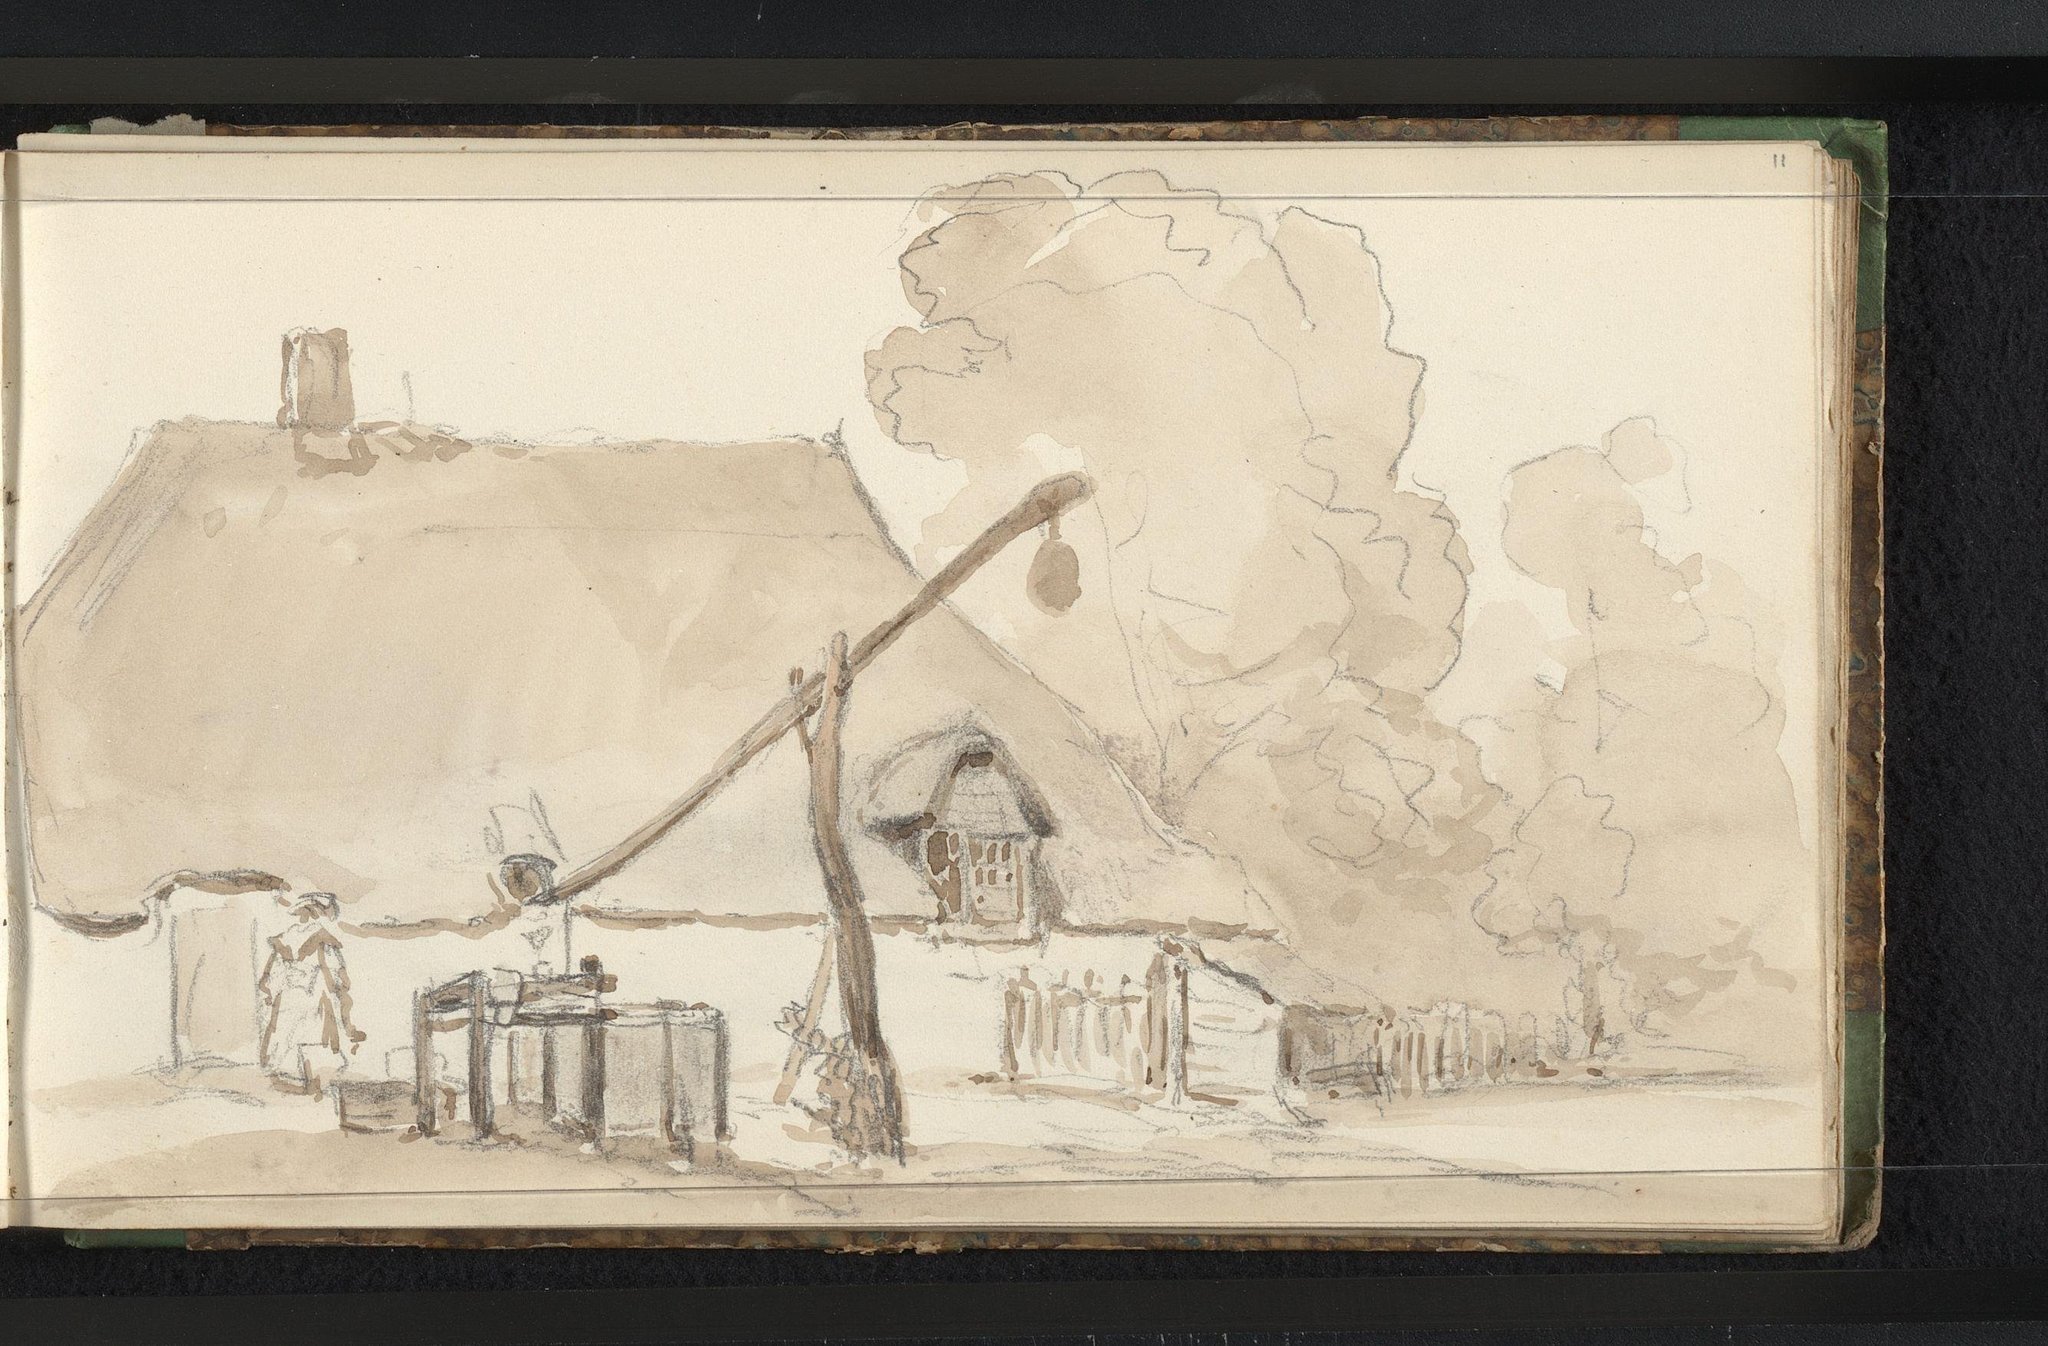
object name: sketchbook leaf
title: Boerderij met waterpomp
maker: jan bedijs tom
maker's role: draughtsman, painter, print maker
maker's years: 1813-1894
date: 1828-1894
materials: paper, pencil, watercolor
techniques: brush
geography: the hague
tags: trees, landscapes, artist (in general) making preliminary designs, sketching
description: Pagina 11 recto uit een schetsboek met 50 bladen.